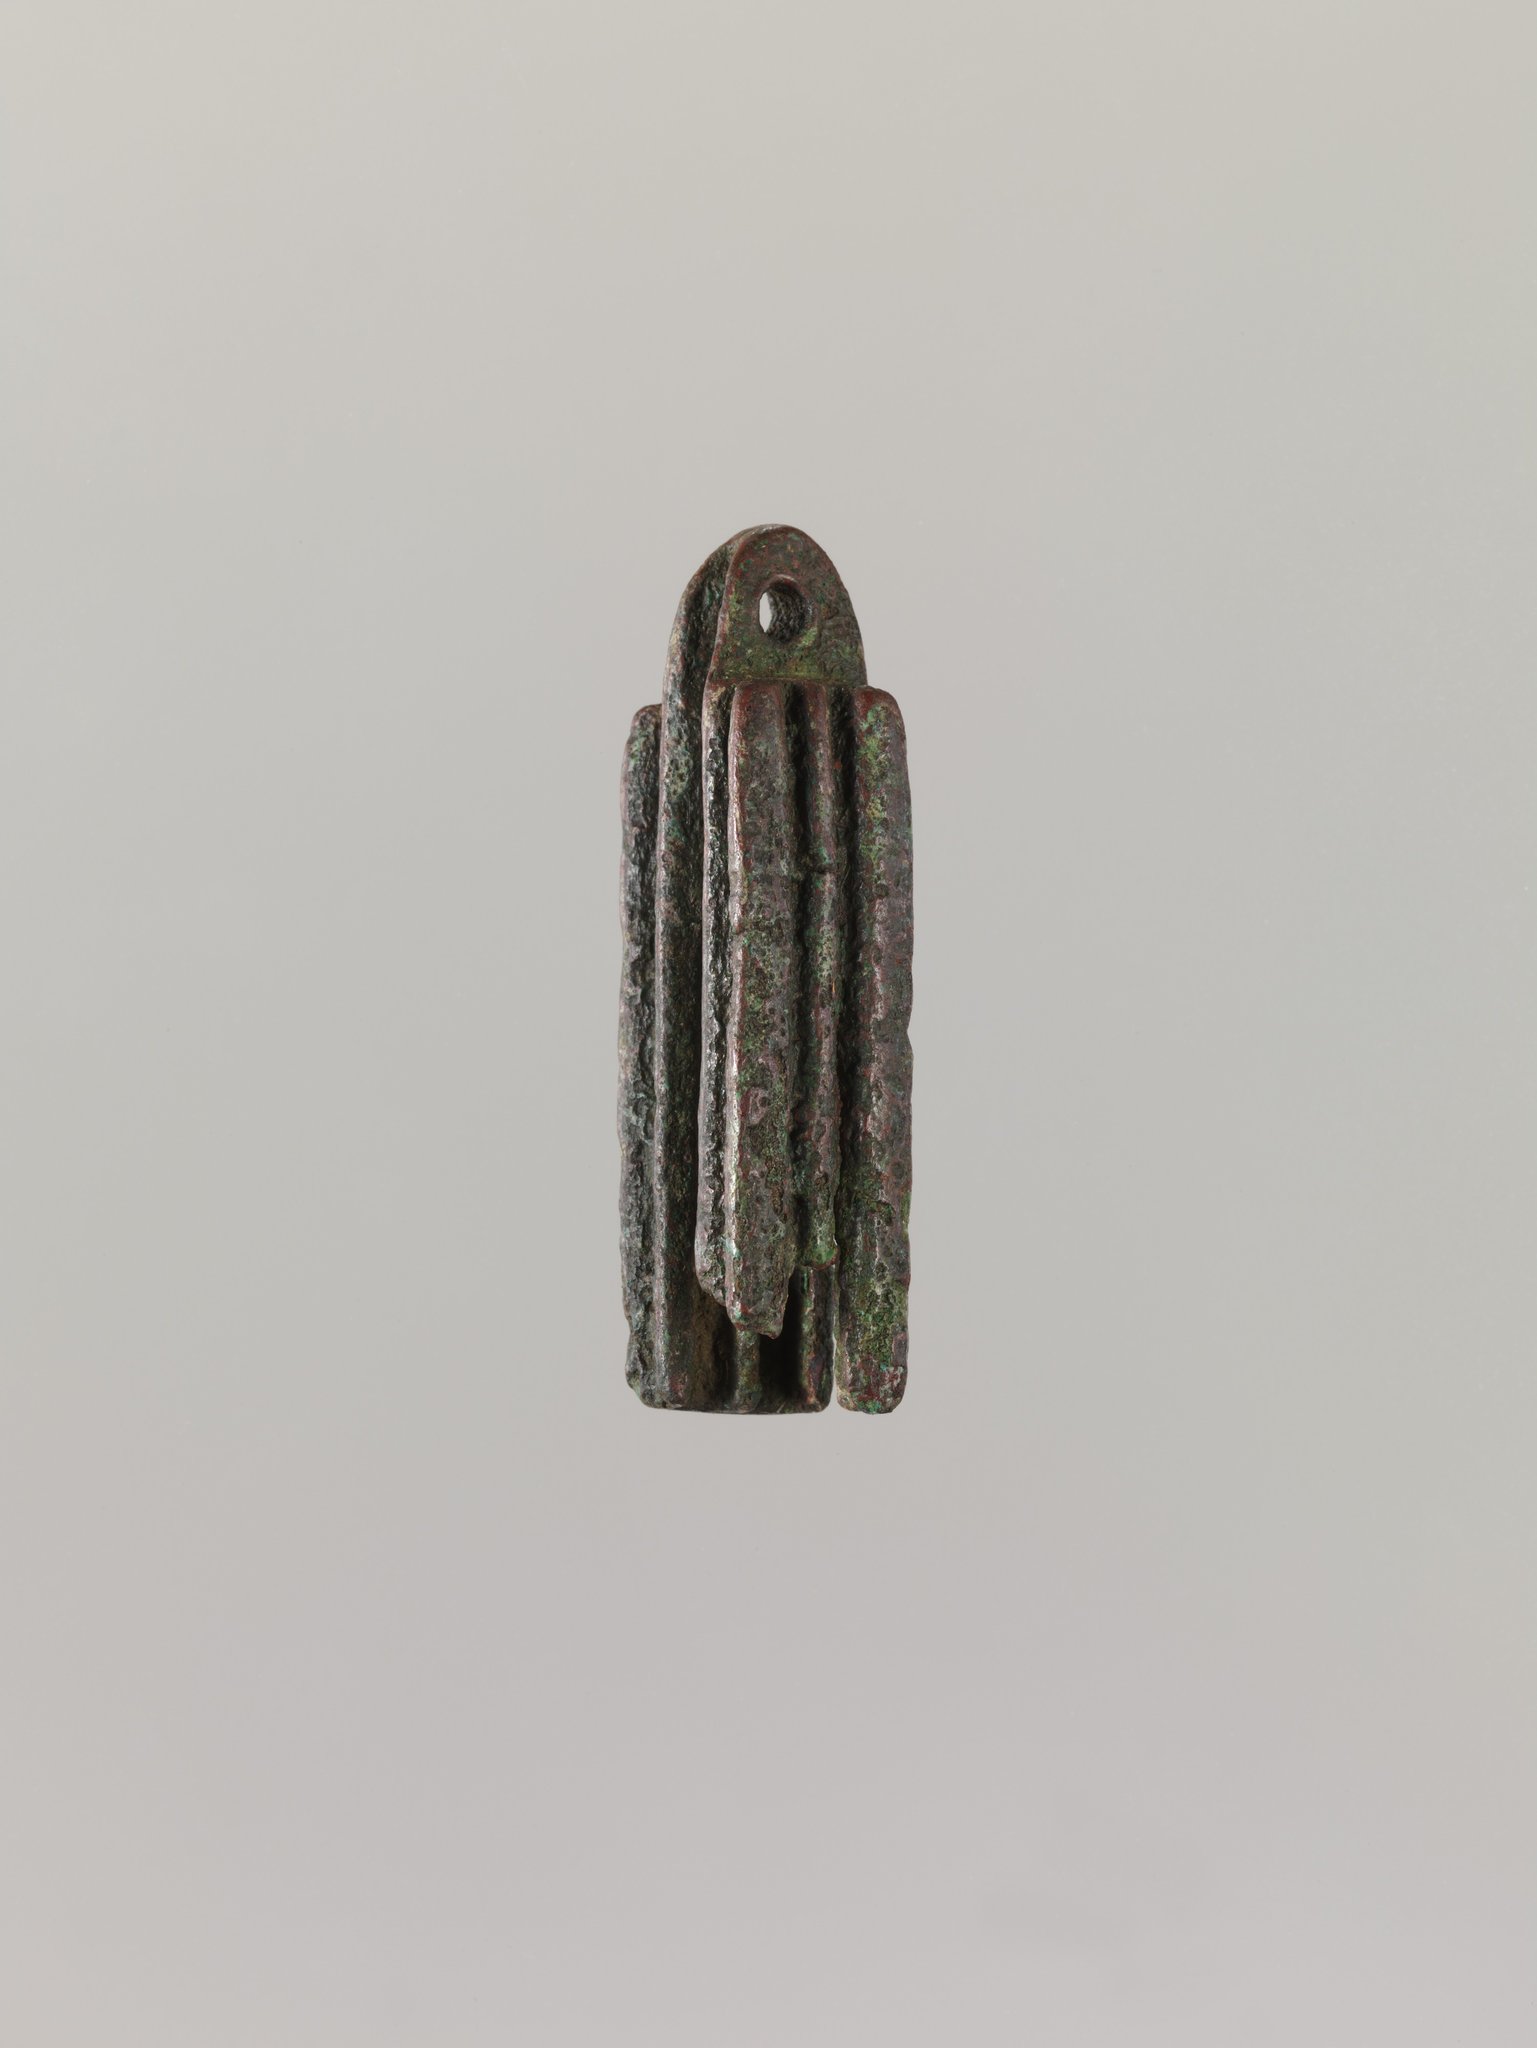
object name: coin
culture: chinese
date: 206 BCE-220 CE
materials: bronze